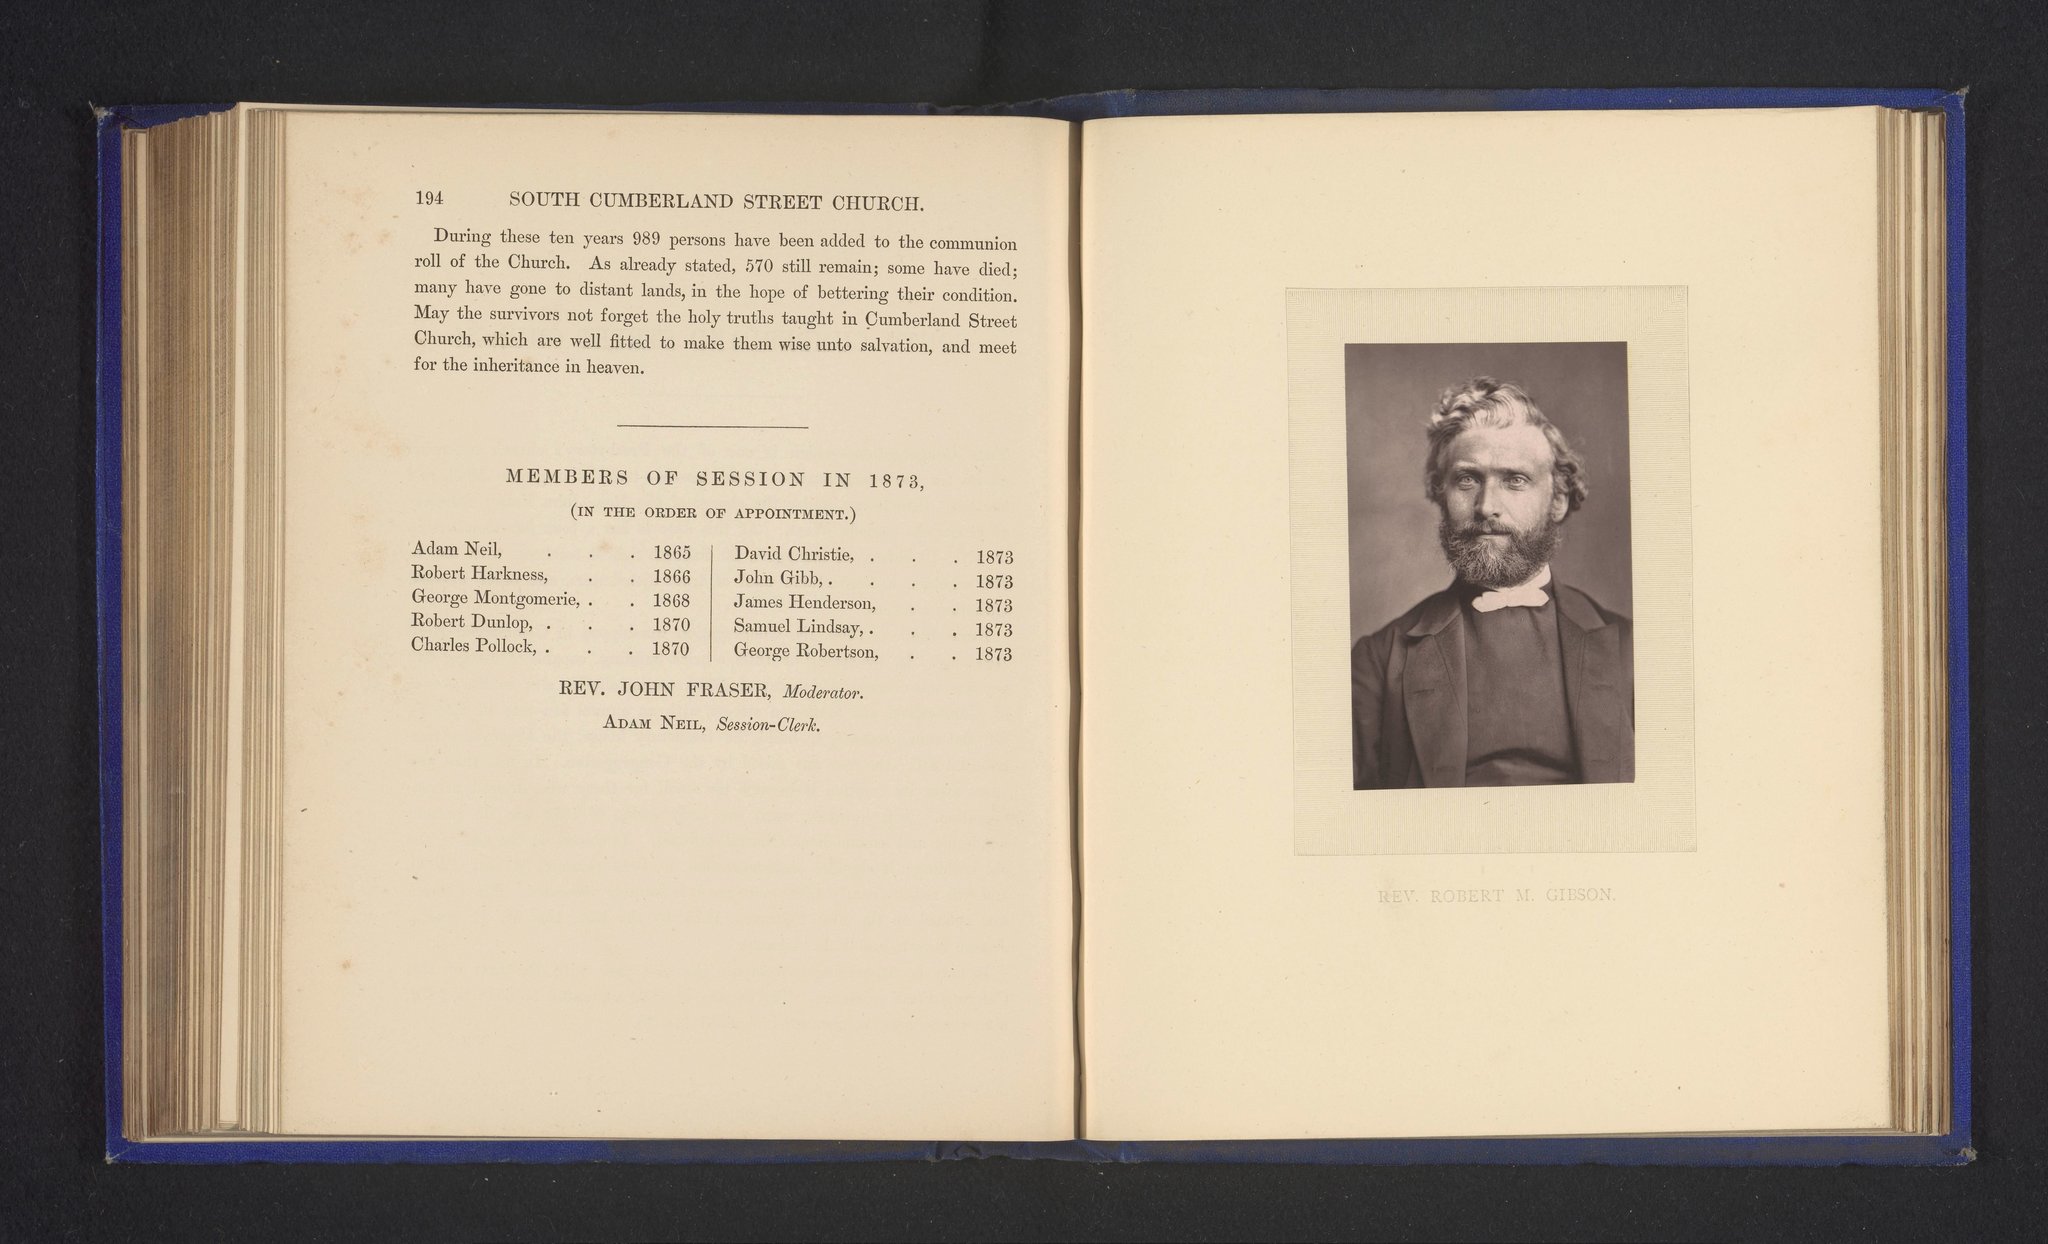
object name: photomechanical print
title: Portret van Robert M. Gibson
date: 1865-1875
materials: paper, photographic support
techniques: carbon print, woodburytype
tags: functionaries and dignitaries (with name) ~ protestant churches